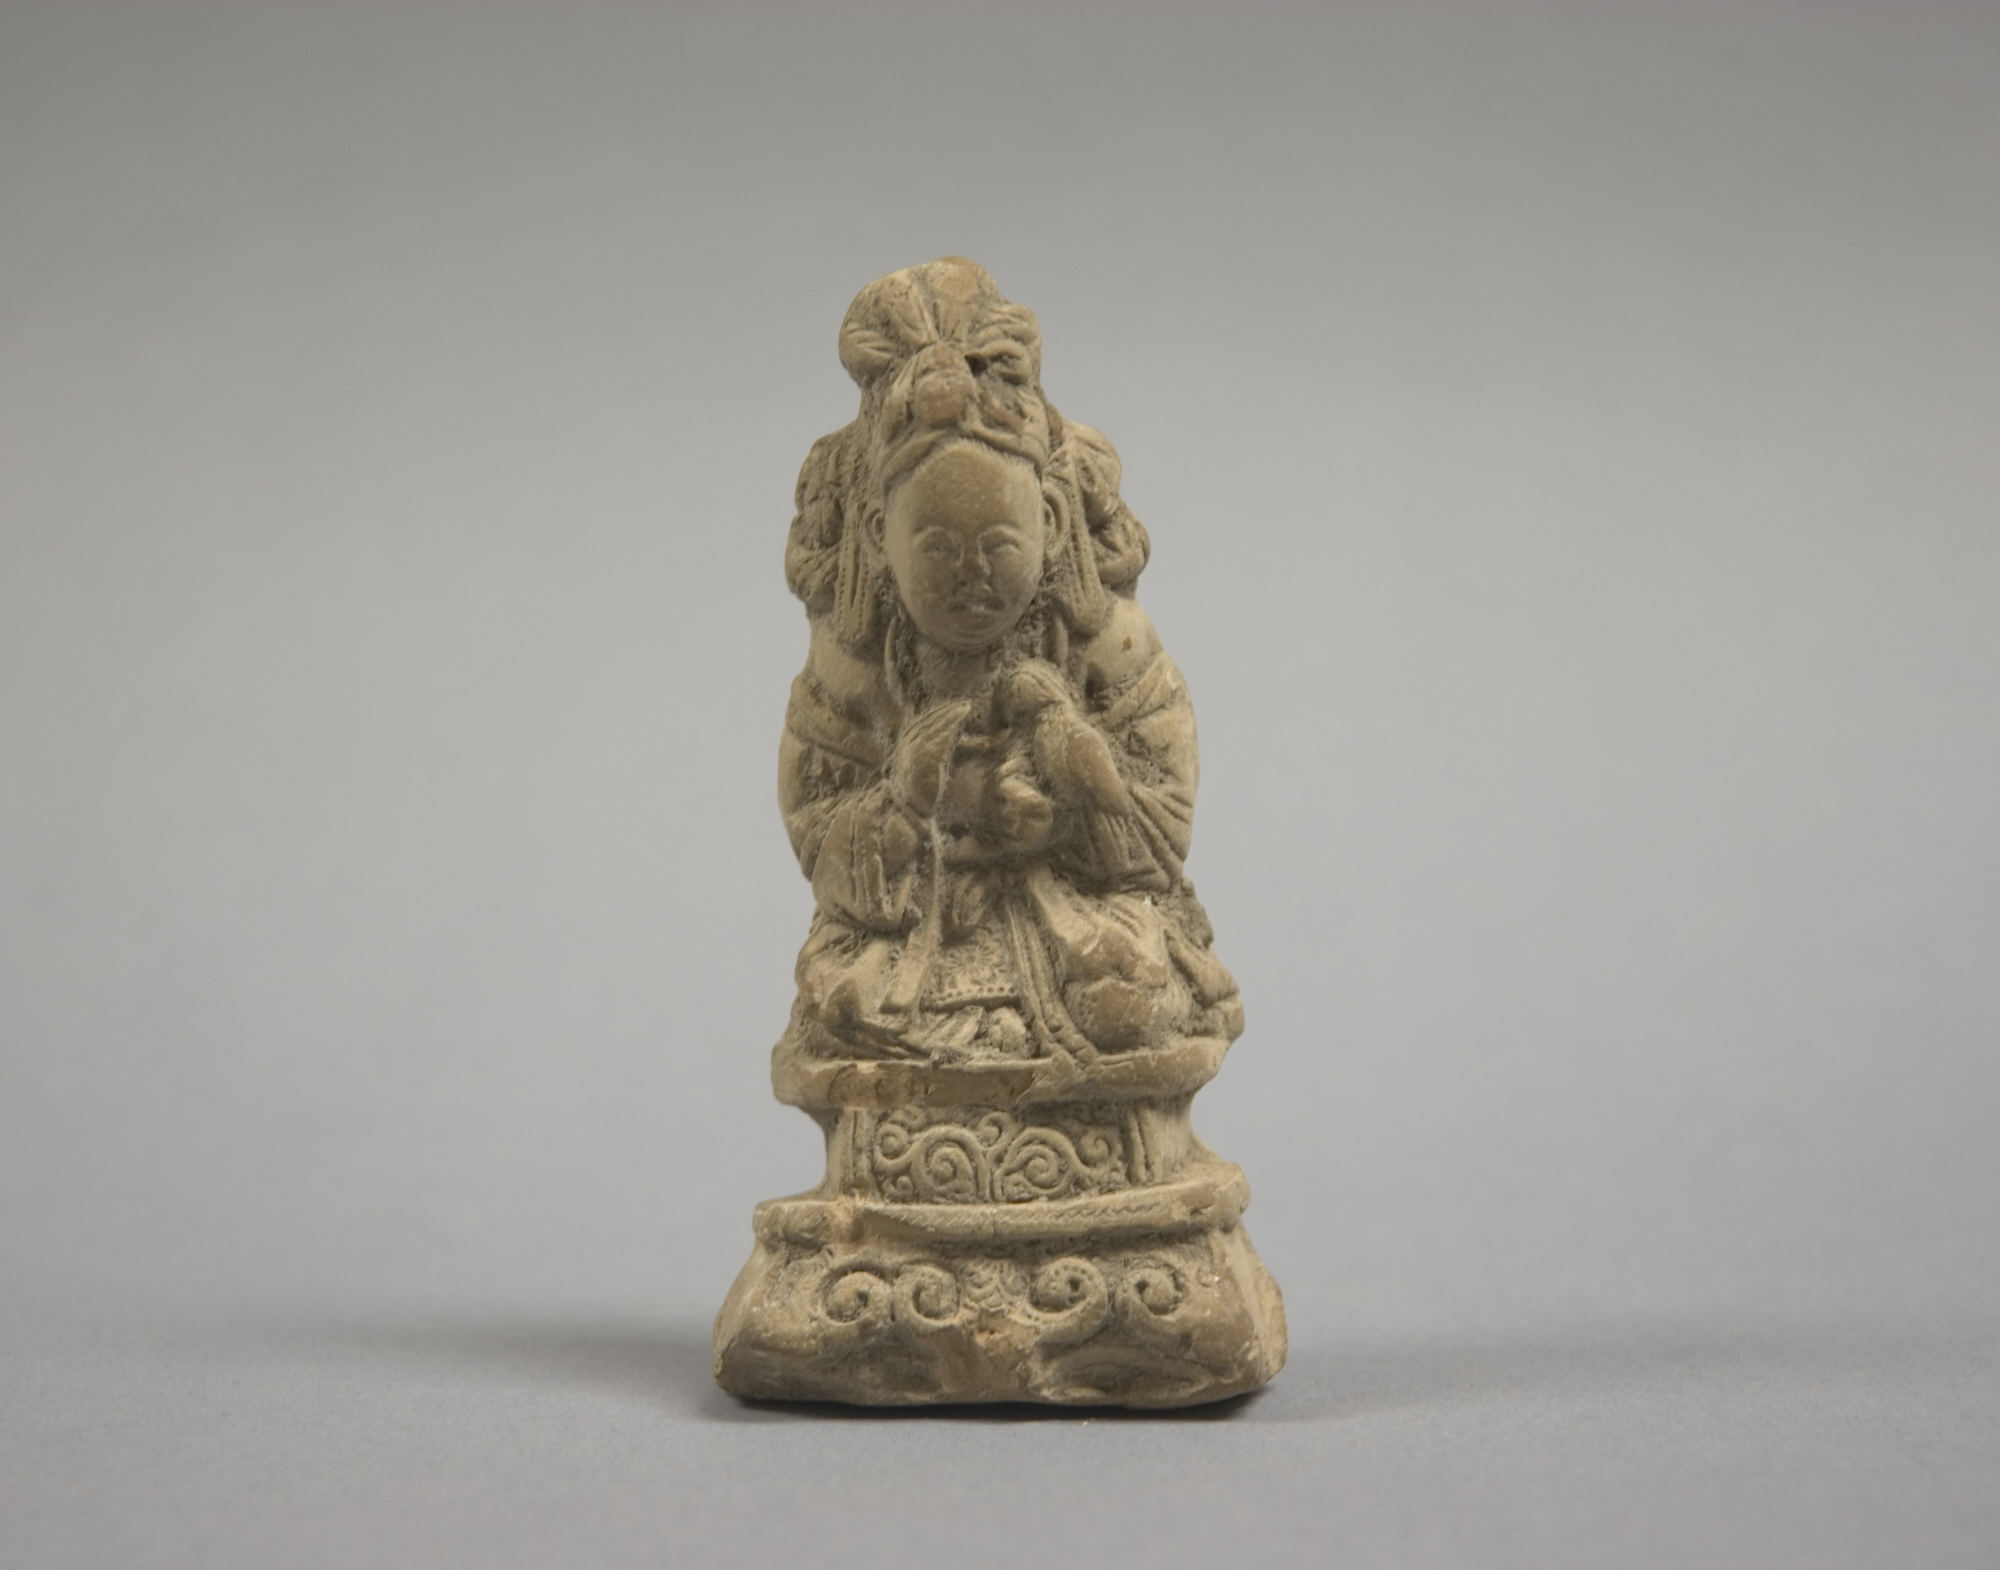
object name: figure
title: Figure of Guanyin with Parrot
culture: chinese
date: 960-1279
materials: pottery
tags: parrots,buddhism,bodhisattvas